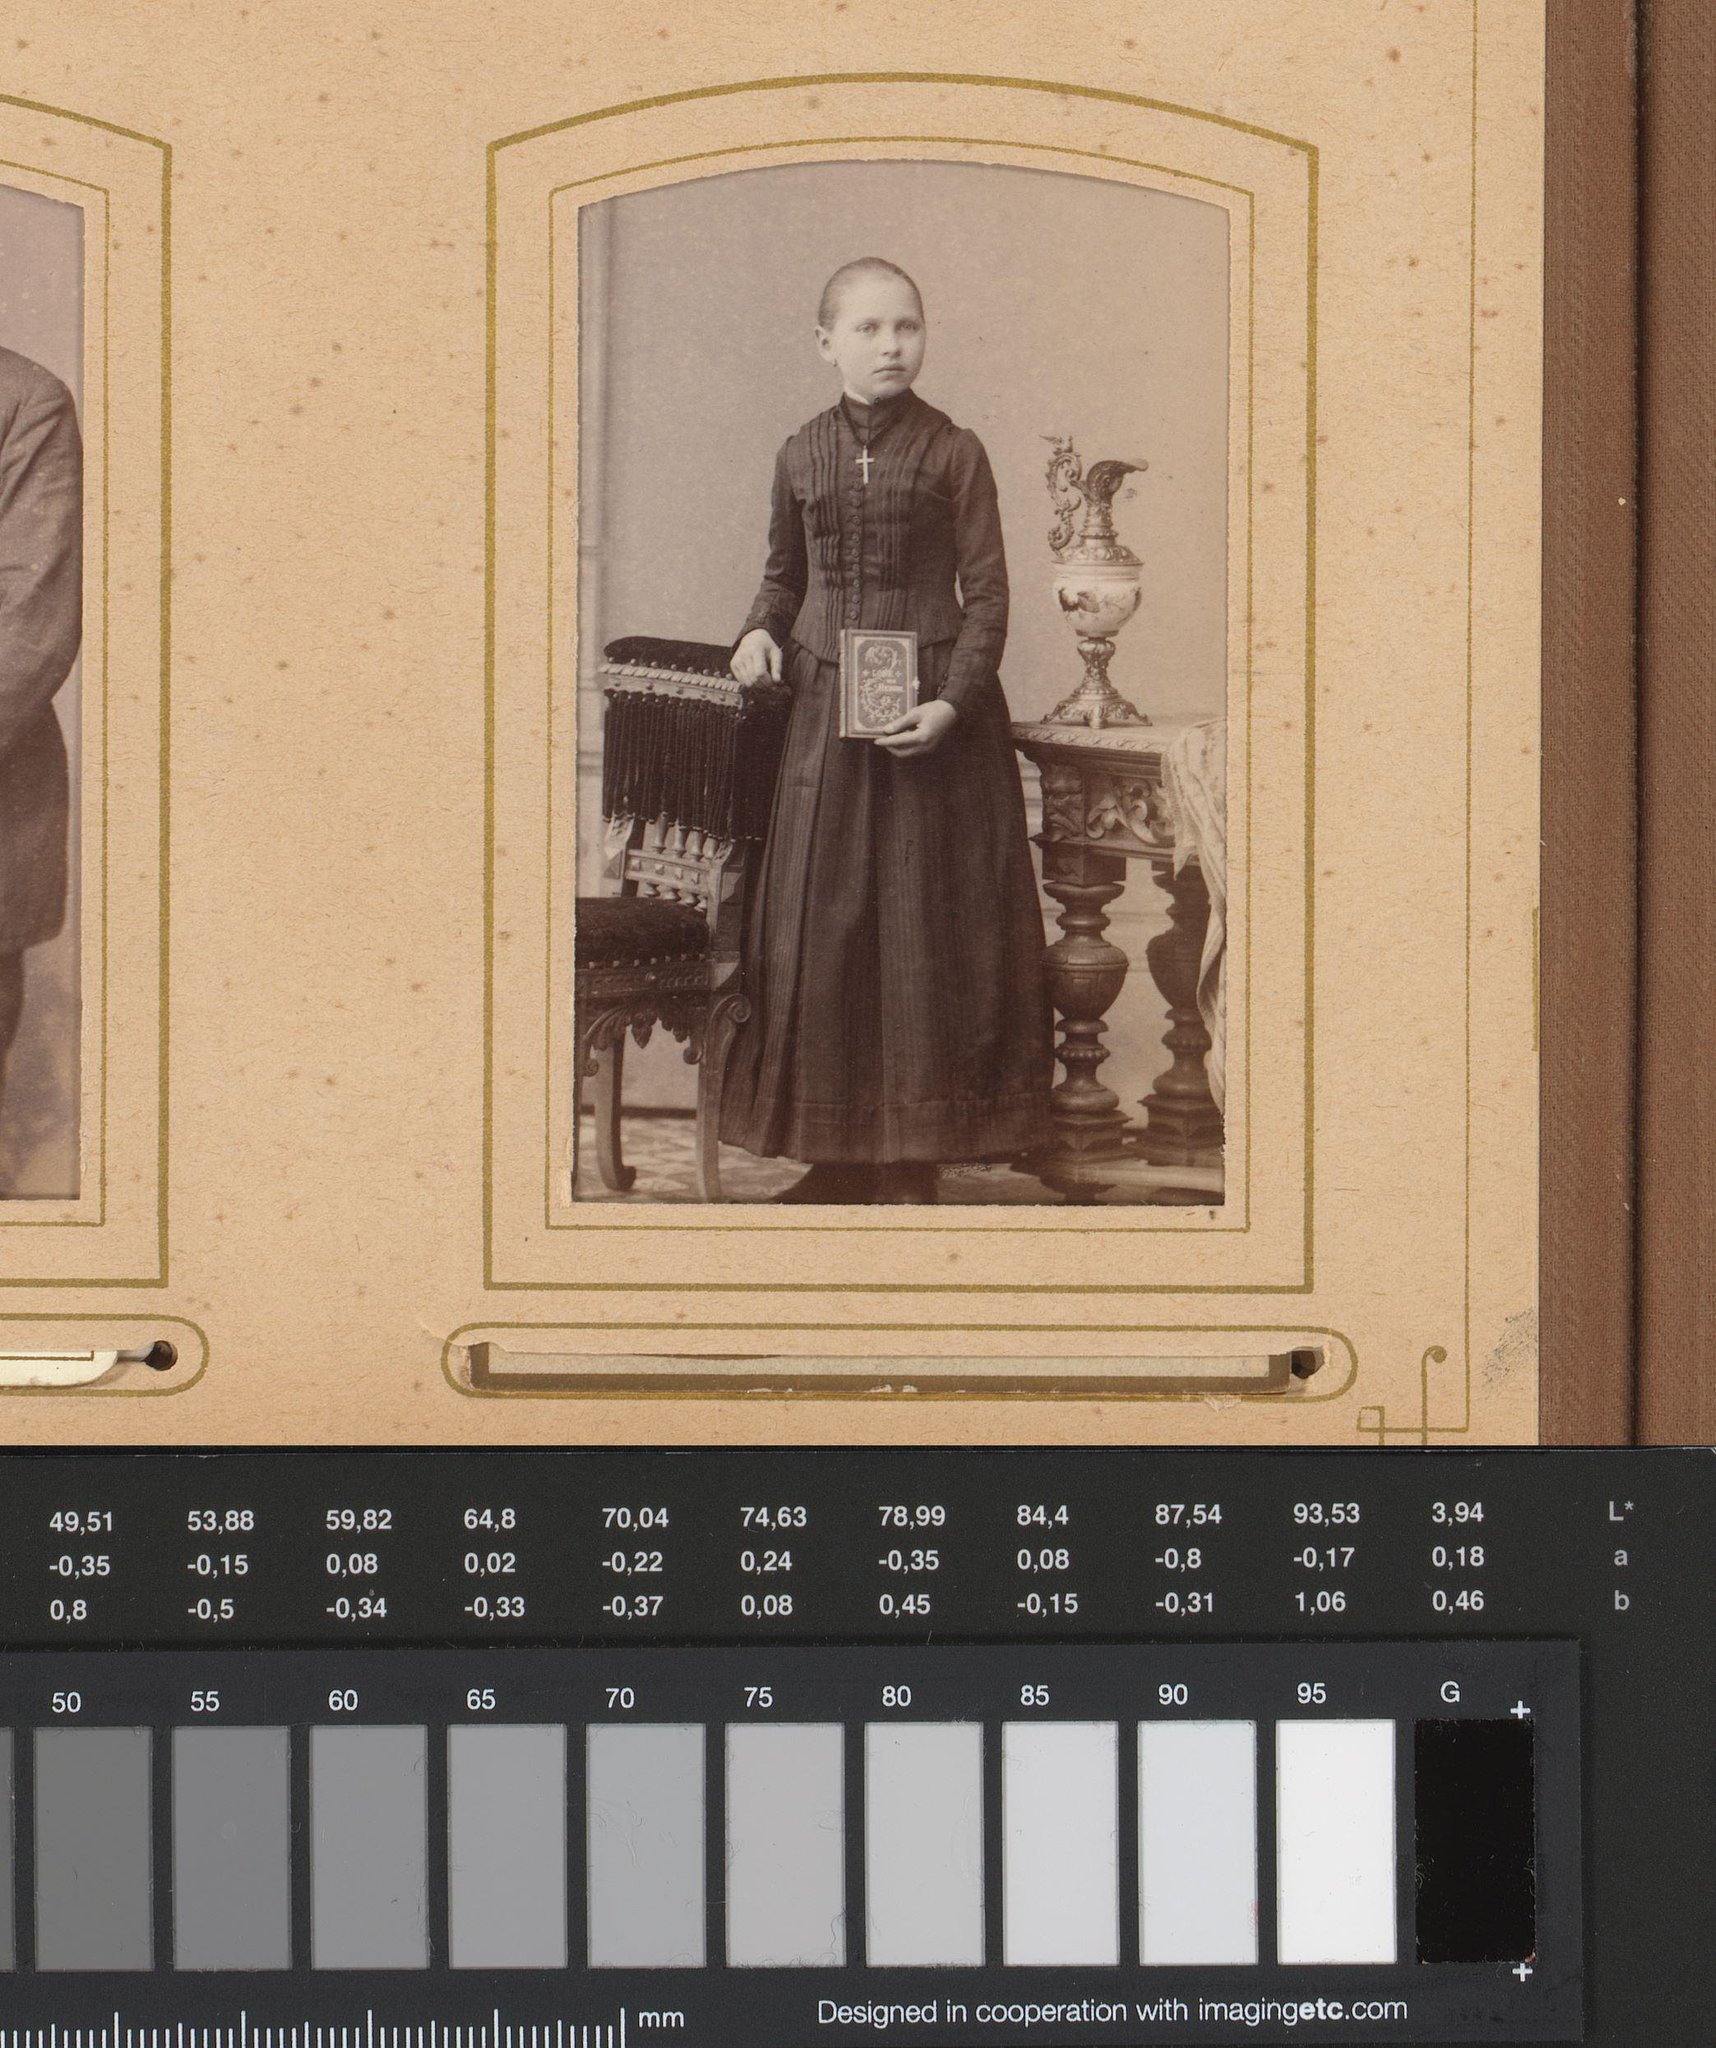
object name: photograph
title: Portret van een staand meisje met boek in de hand met de titel Lobe den Herrn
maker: clemens seeber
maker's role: fotograaf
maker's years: 1851-1905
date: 1891-1900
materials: cardboard, photographic support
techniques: albumen print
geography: chemnitz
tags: historical persons - bb - woman, girl (child between toddler and youth), book, standing figure - aa - female human figure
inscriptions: inscription: ‘Photographisches/ Institut./ Clemens Seeber/ in meinem/ eigenen Hause/ Theaterstr. 22,/ I. Etage./ Chemnitz./ 1891/ Die Originalplatte dieses Bild ist aufbewahrt und man kann selbst nach/ einigen Jahren abzüge bestellen, die ebenso sortfältig ausgeführt sind.’